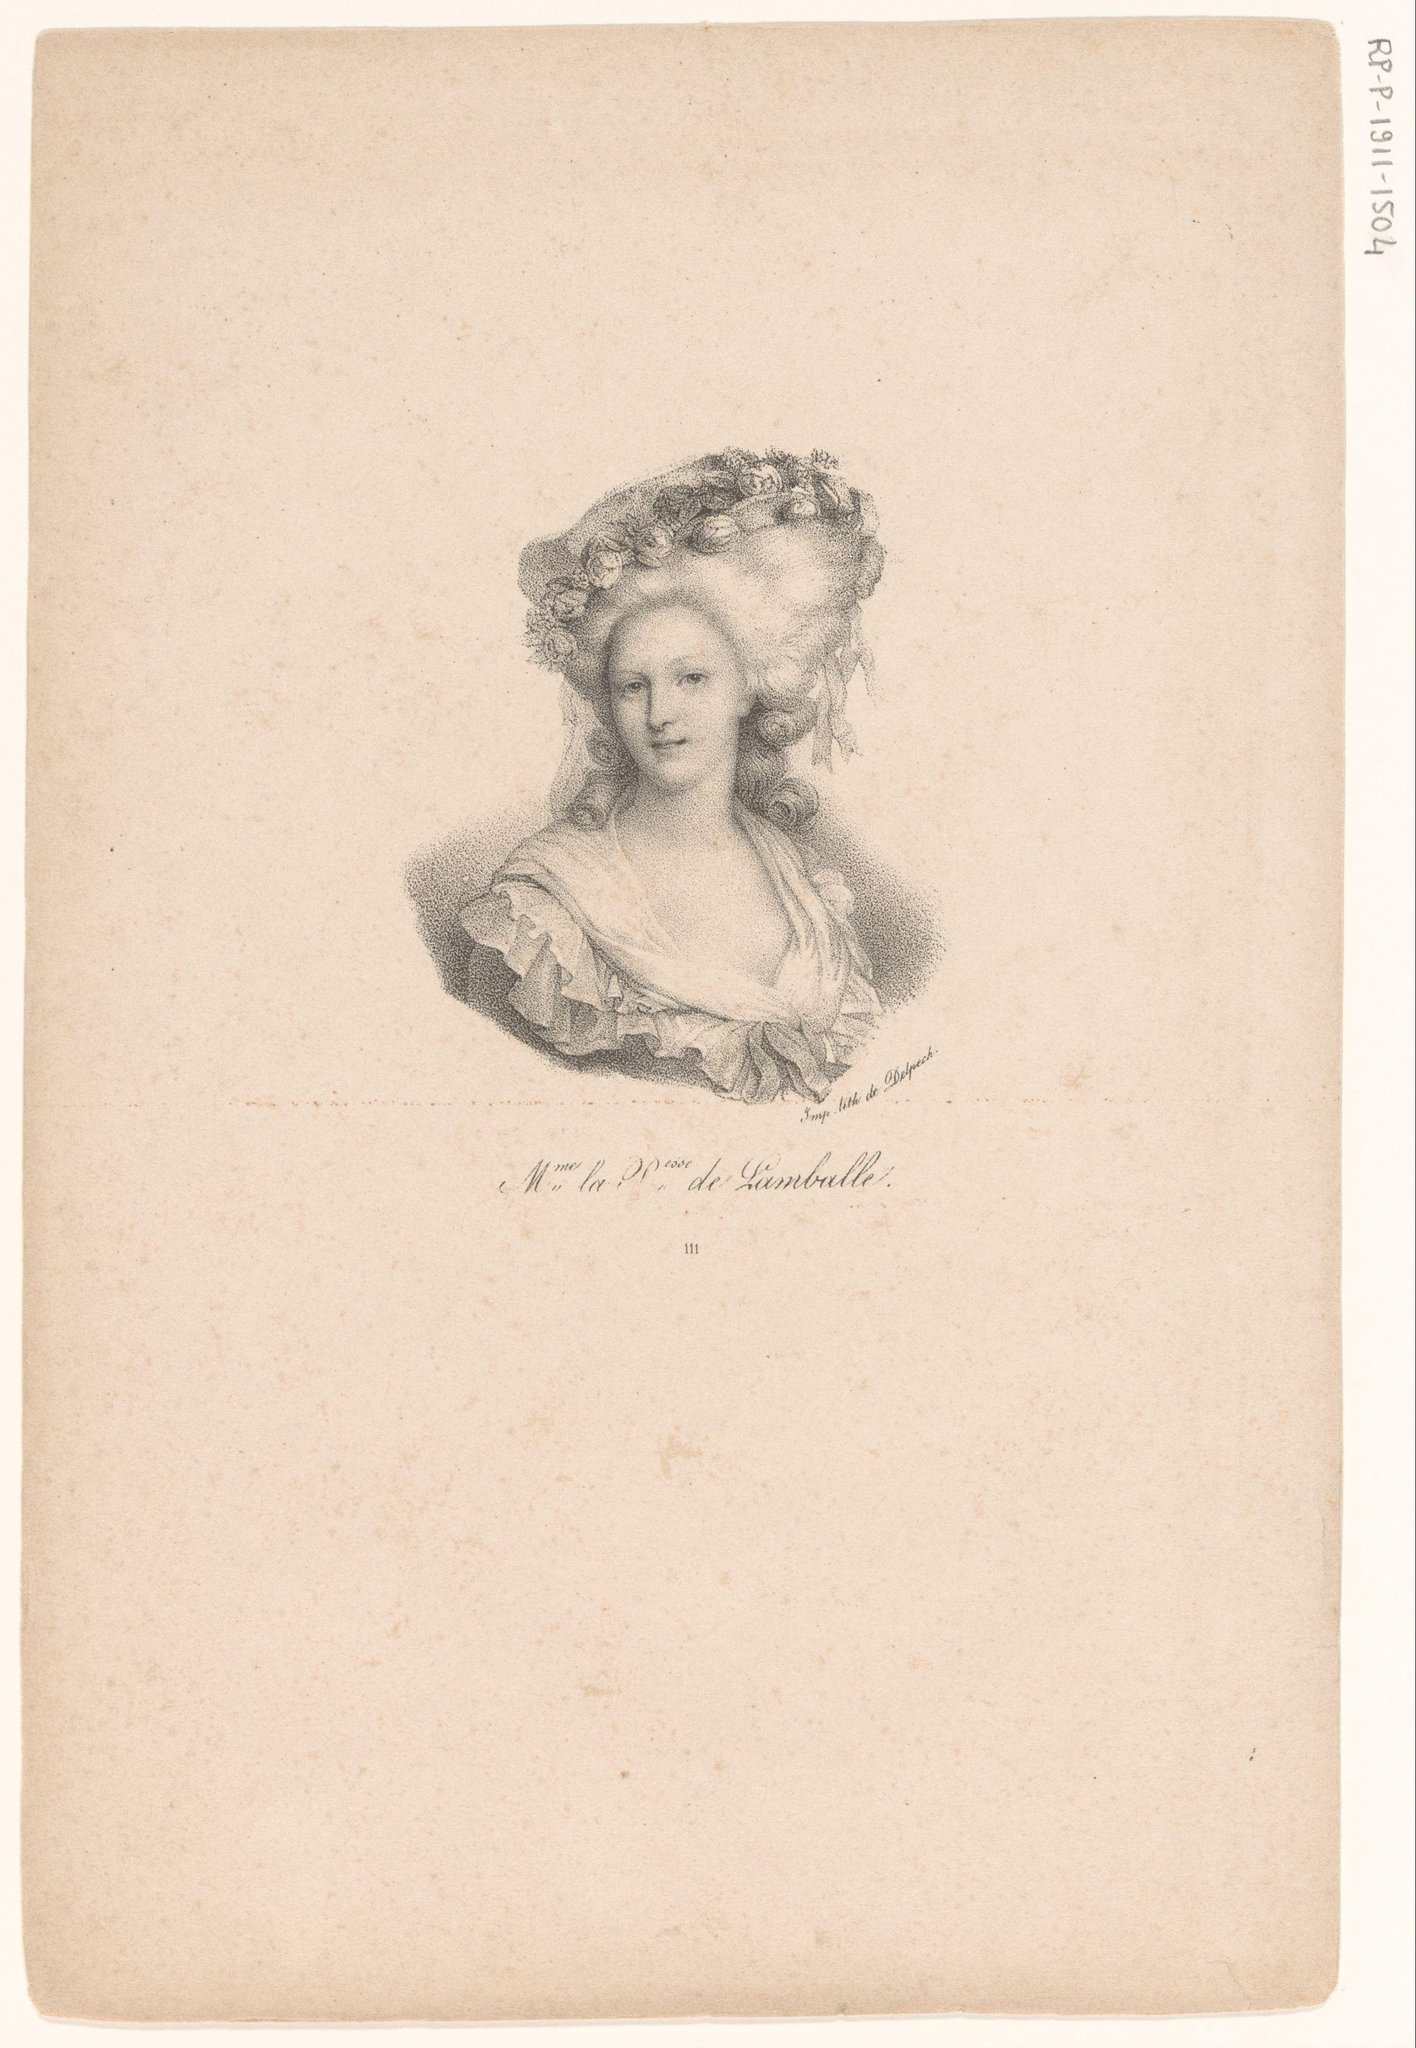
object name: print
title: Portret van Maria Louise van Savoye, Prinses de Lamballe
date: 1818-1842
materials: paper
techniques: lithograph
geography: paris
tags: paris, historical persons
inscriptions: collector's mark: Lugt 2228a